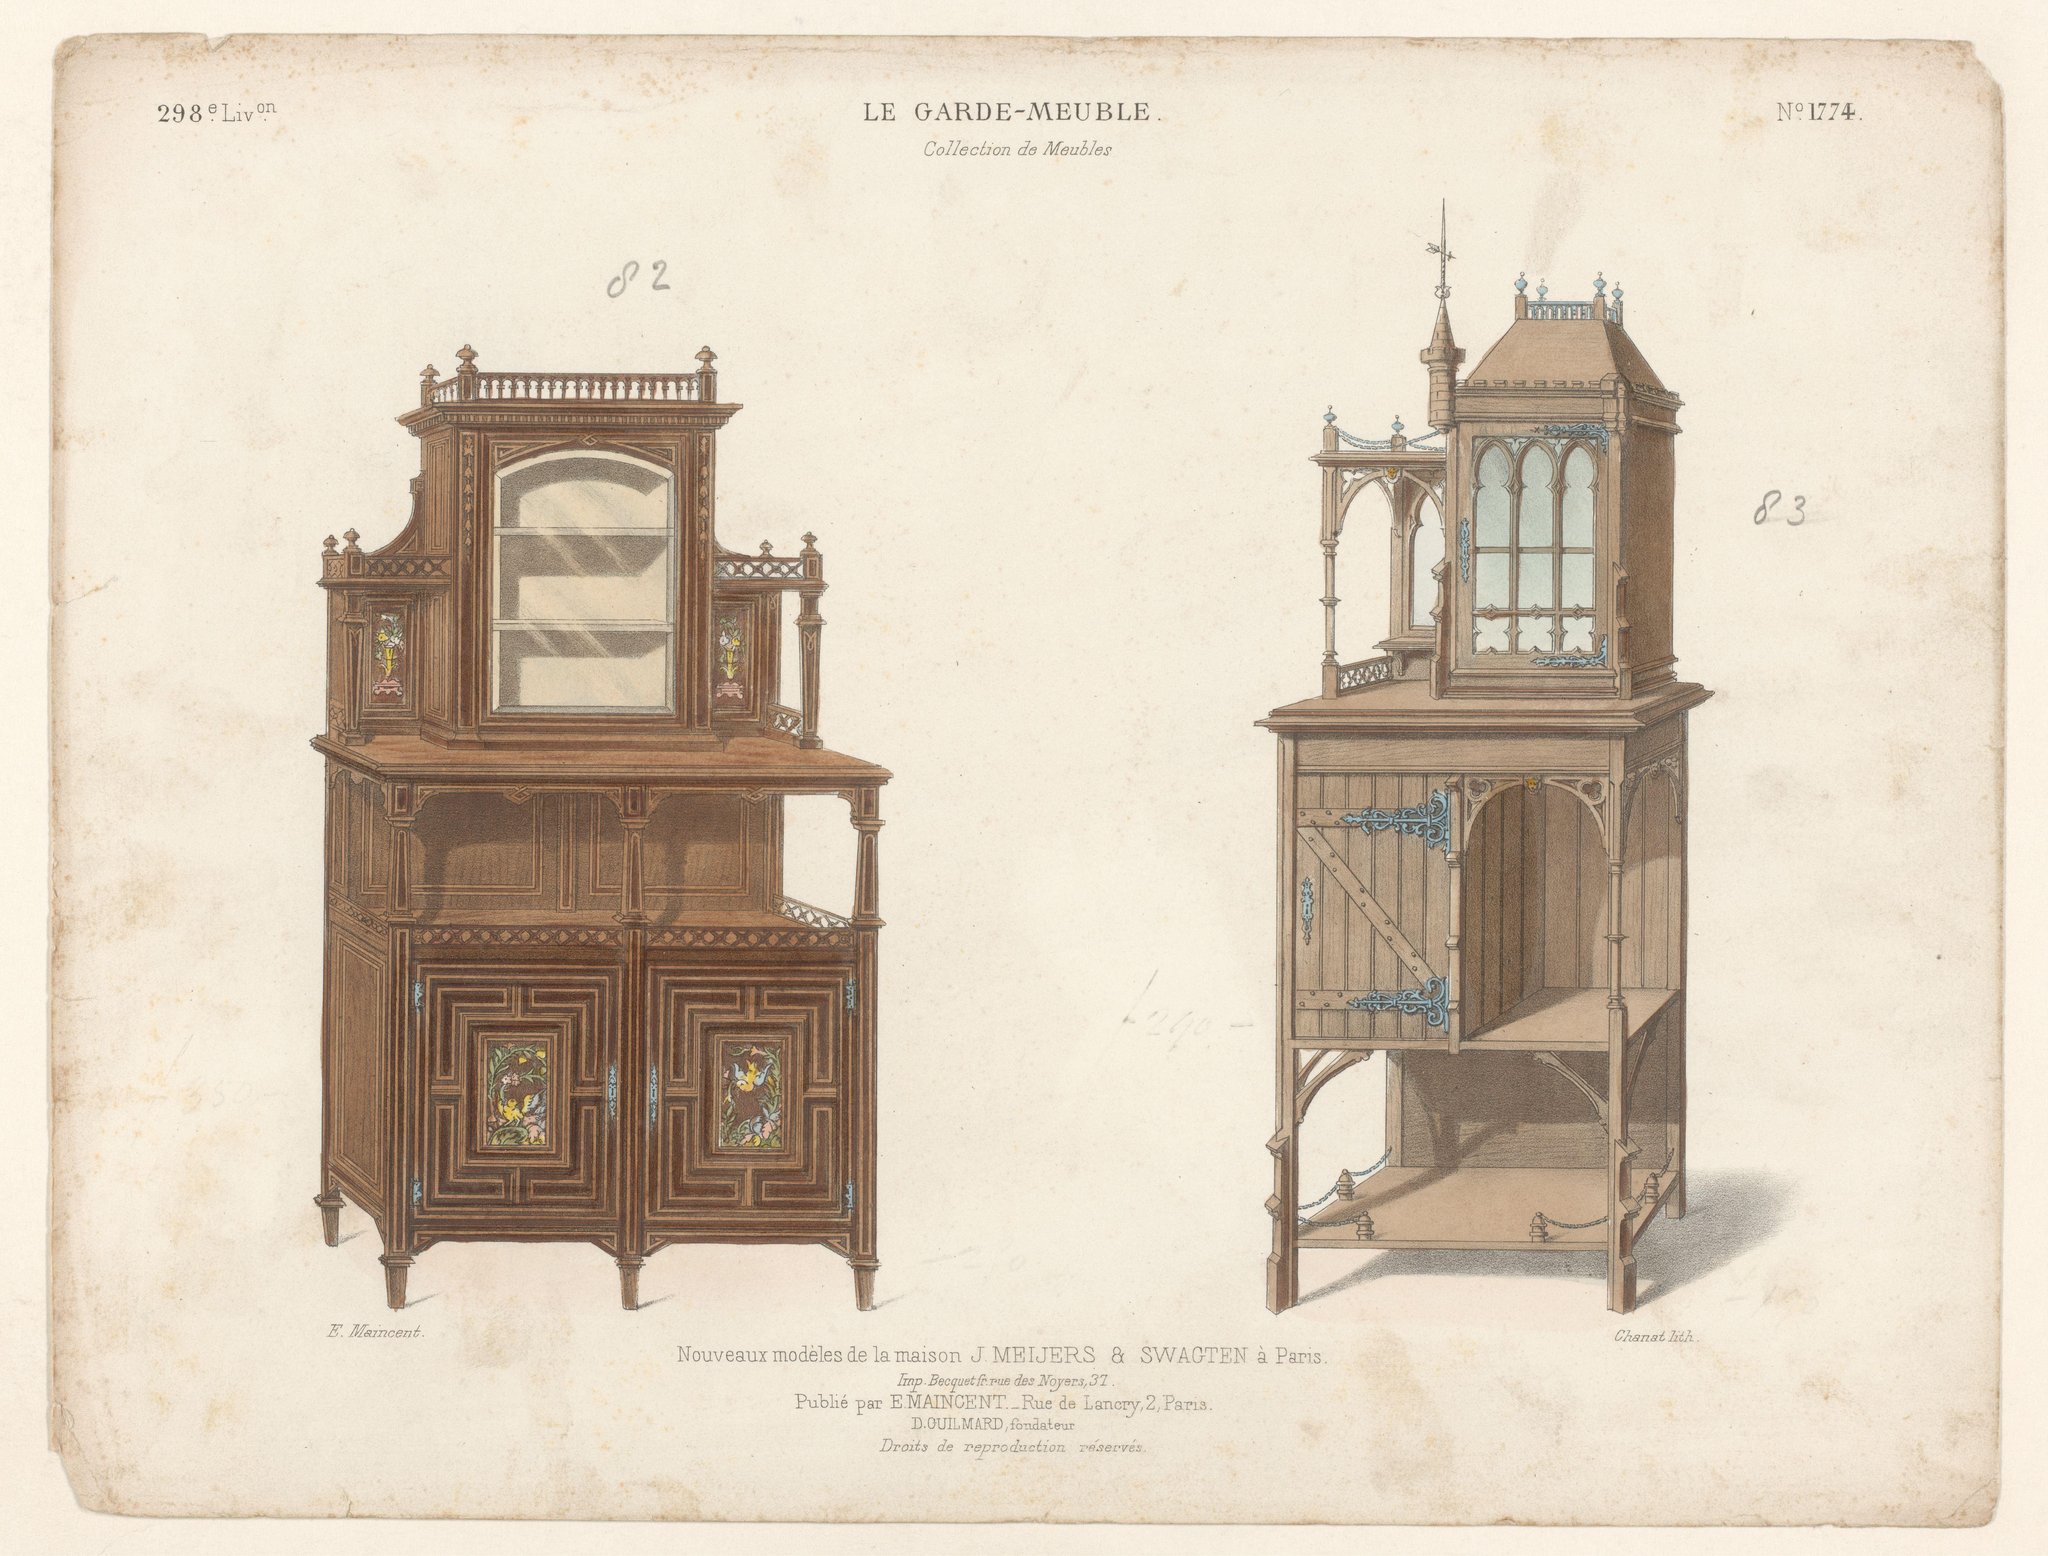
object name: print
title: Nouveau modèles de la maison J. Meijers & Swagten à Paris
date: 1885-1895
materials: paper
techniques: hand coloring, lithograph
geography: paris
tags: furniture for storage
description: Ieder Livraison in de serie Le Garde-Meuble bevat negen platen: drie 'sièges' (zitmeubels), drie 'meubles' (diverse meubels zoals tafels en kasten) en drie 'tentures' (gordijnen en draperieën).